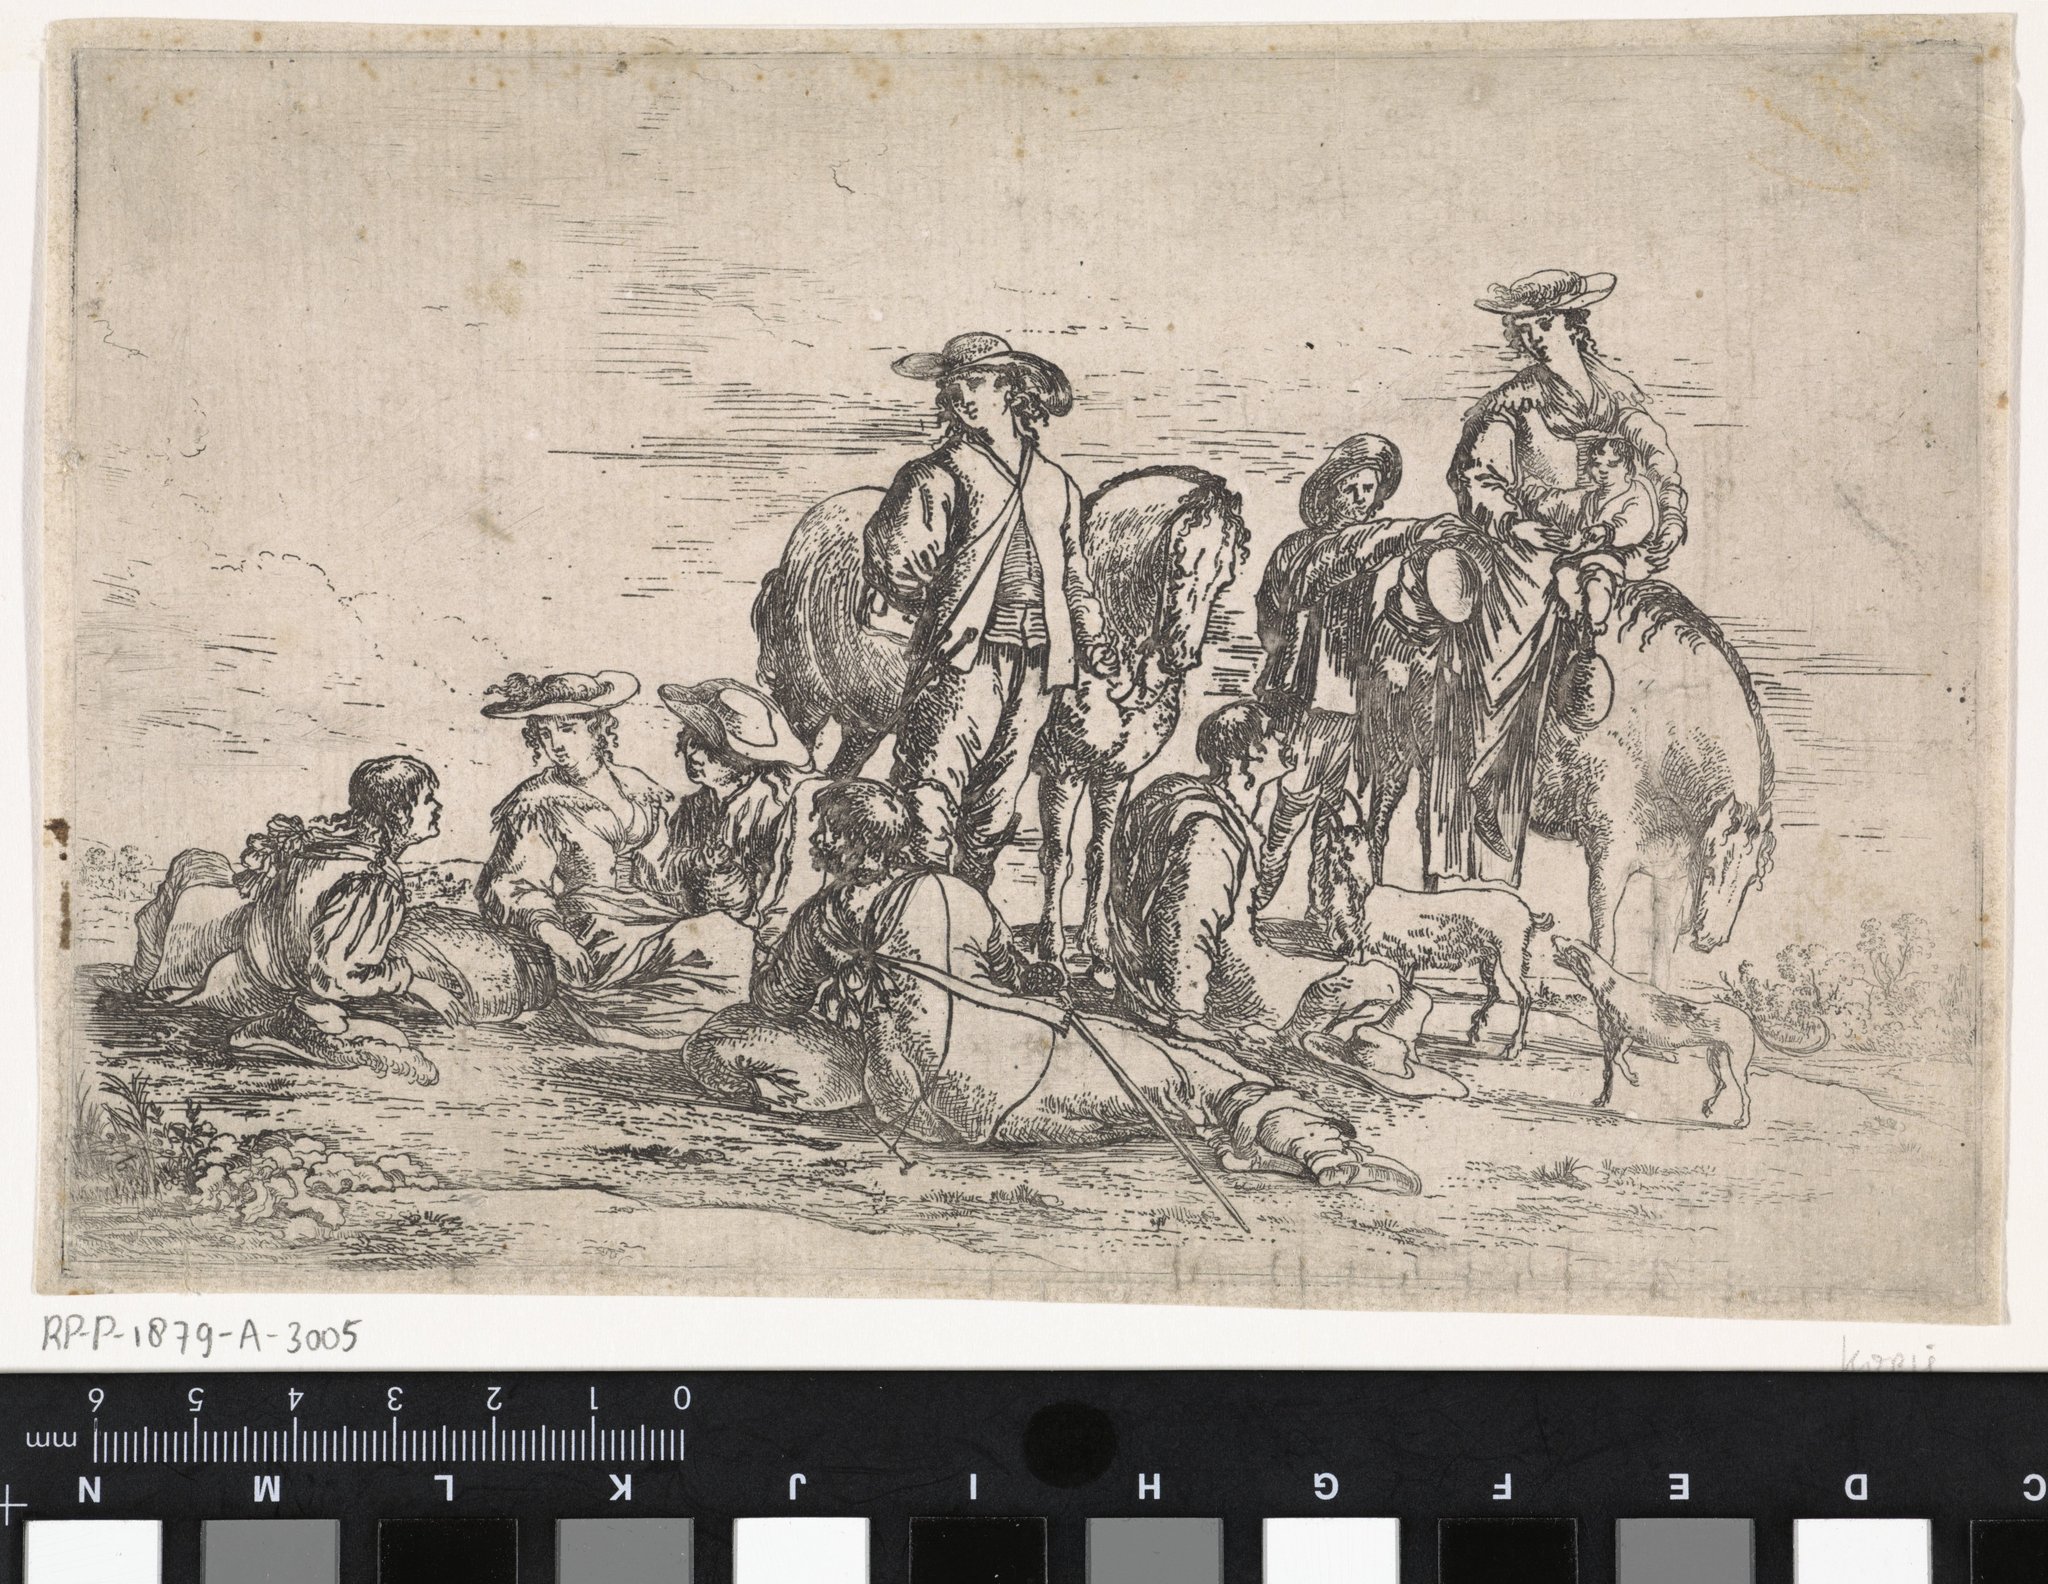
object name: print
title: Rustend jachtgezelschap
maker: Anonymous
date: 1630-1698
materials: paper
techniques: etching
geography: italy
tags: hunters resting during the hunt, goat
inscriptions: collector's mark: Lugt 2228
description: Een groep ruiters neemt een pauze. Ze zijn met elkaar in gesprek. Eén vrouw zit nog met haar kind op het paard. Rechts een geit en een hond.